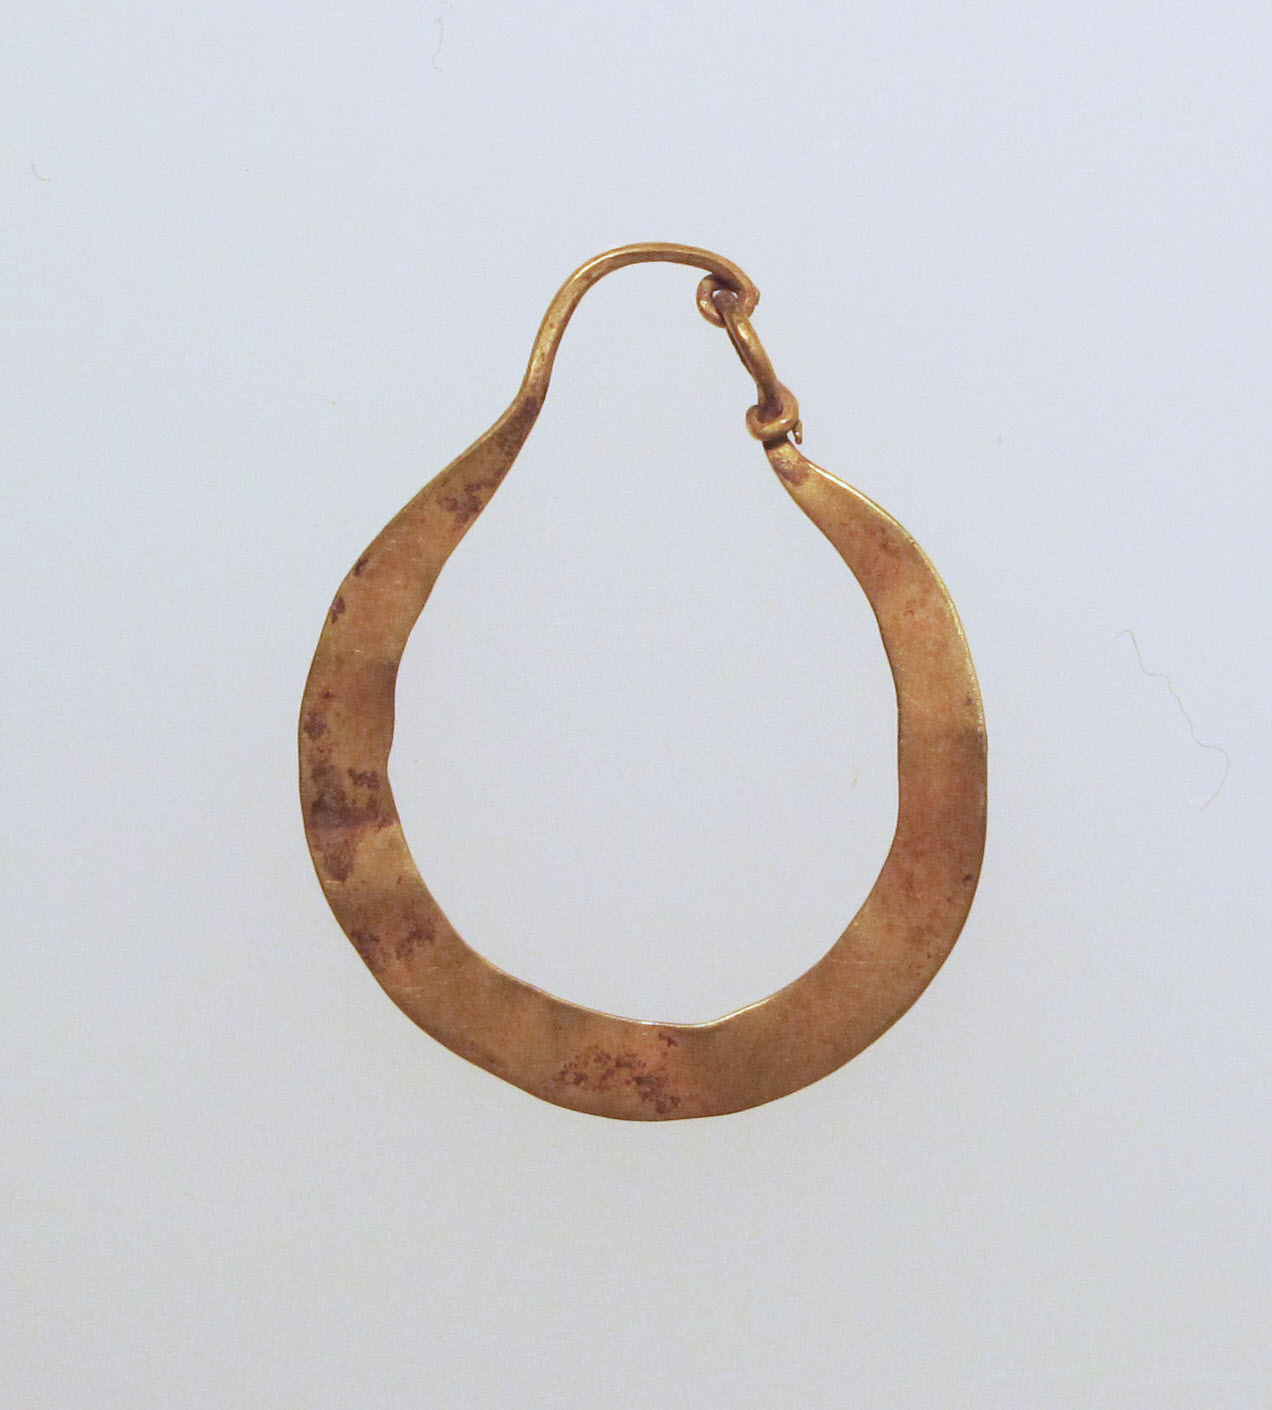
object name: earring, crescent shaped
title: Earring, crescent-shaped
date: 7000 BCE-330 CE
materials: gold